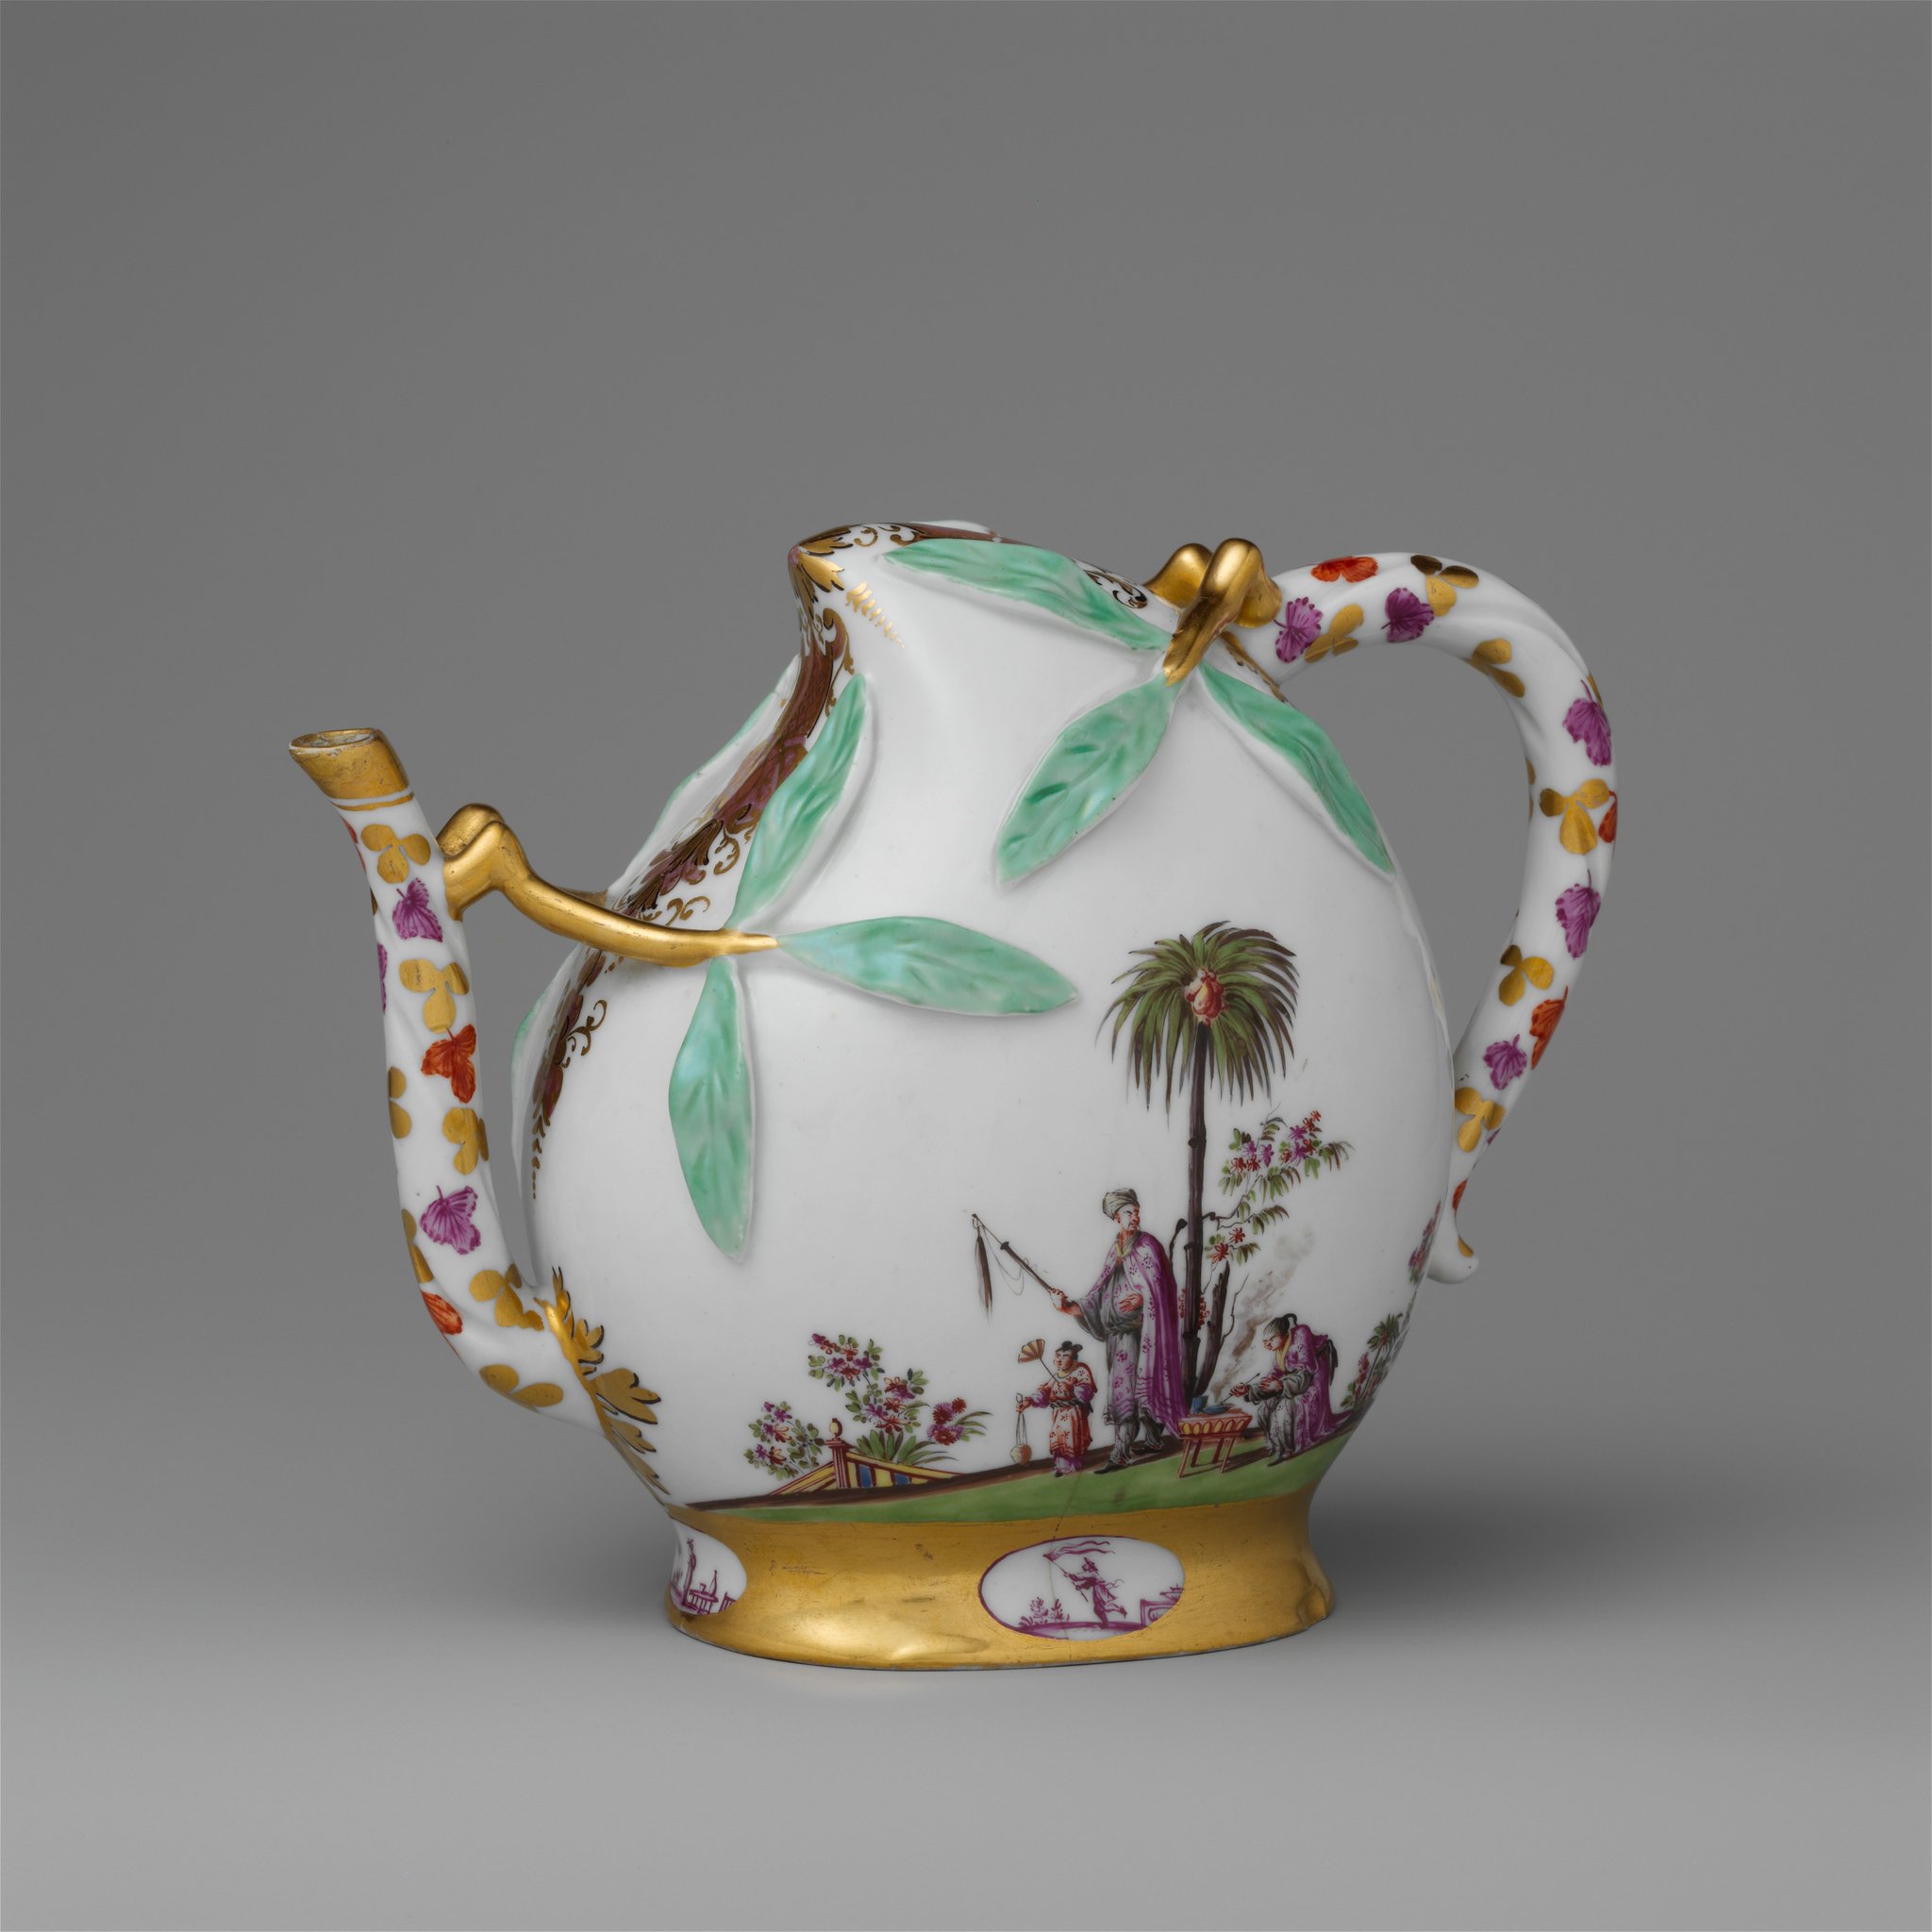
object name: wine pot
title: Wine pot in the shape of a peach (cadogan type)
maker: meissen manufactory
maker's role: manufactory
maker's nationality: german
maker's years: 1710-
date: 1725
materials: enamel, gold, hard paste porcelain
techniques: polychrome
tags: children,men,women,palms